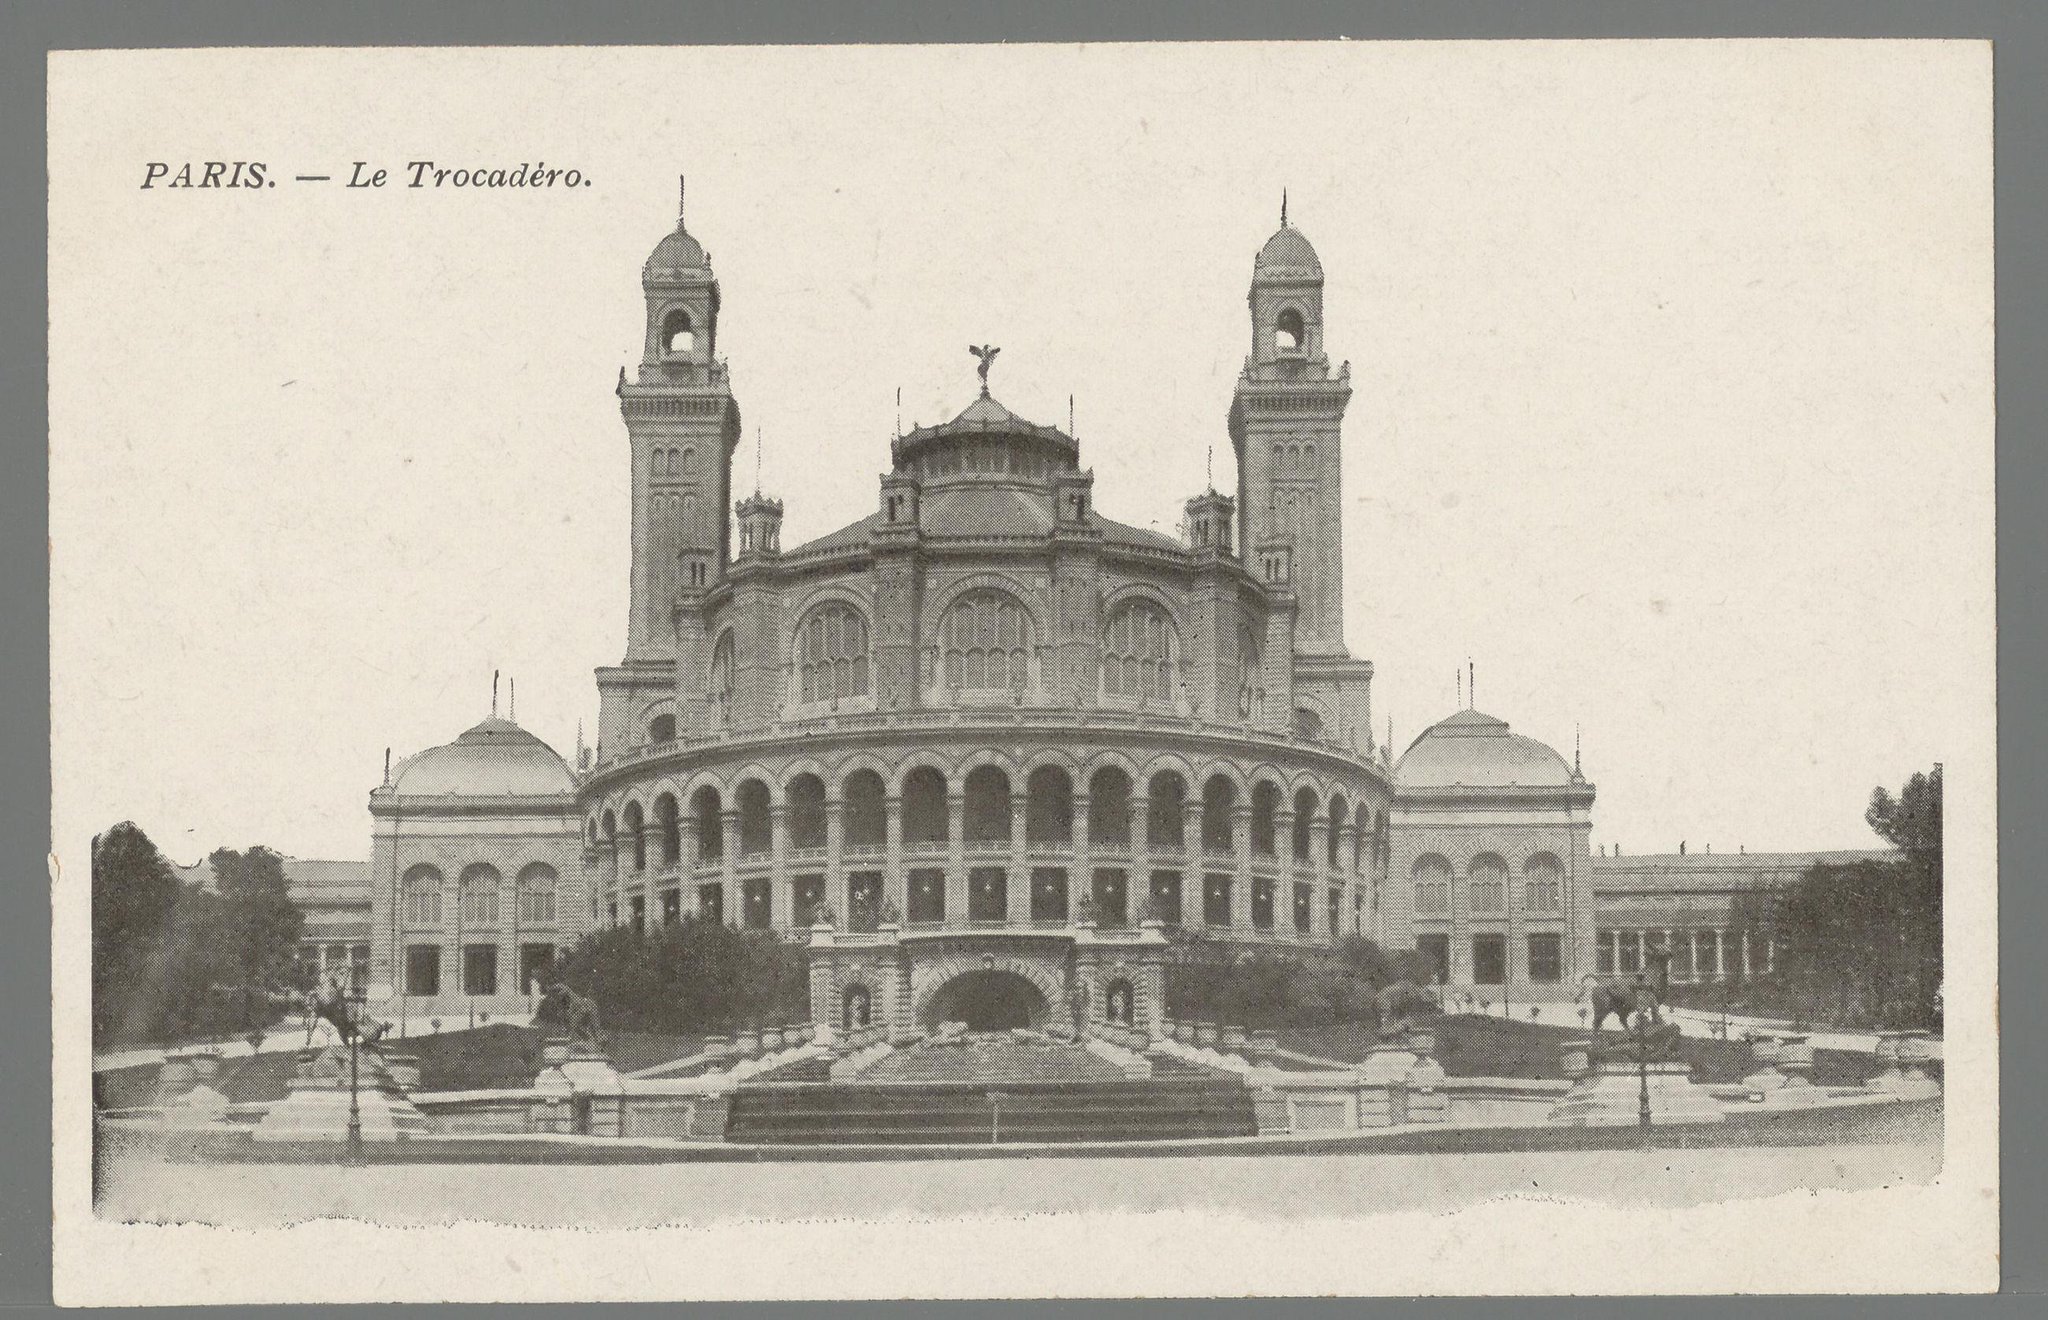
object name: ansichtkaart, prentbriefkaart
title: Paris. Le Trocadéro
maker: Anonymous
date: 1904-1906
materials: cardboard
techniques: autotype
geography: paris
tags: city-view, and landscape with man-made constructions, palace